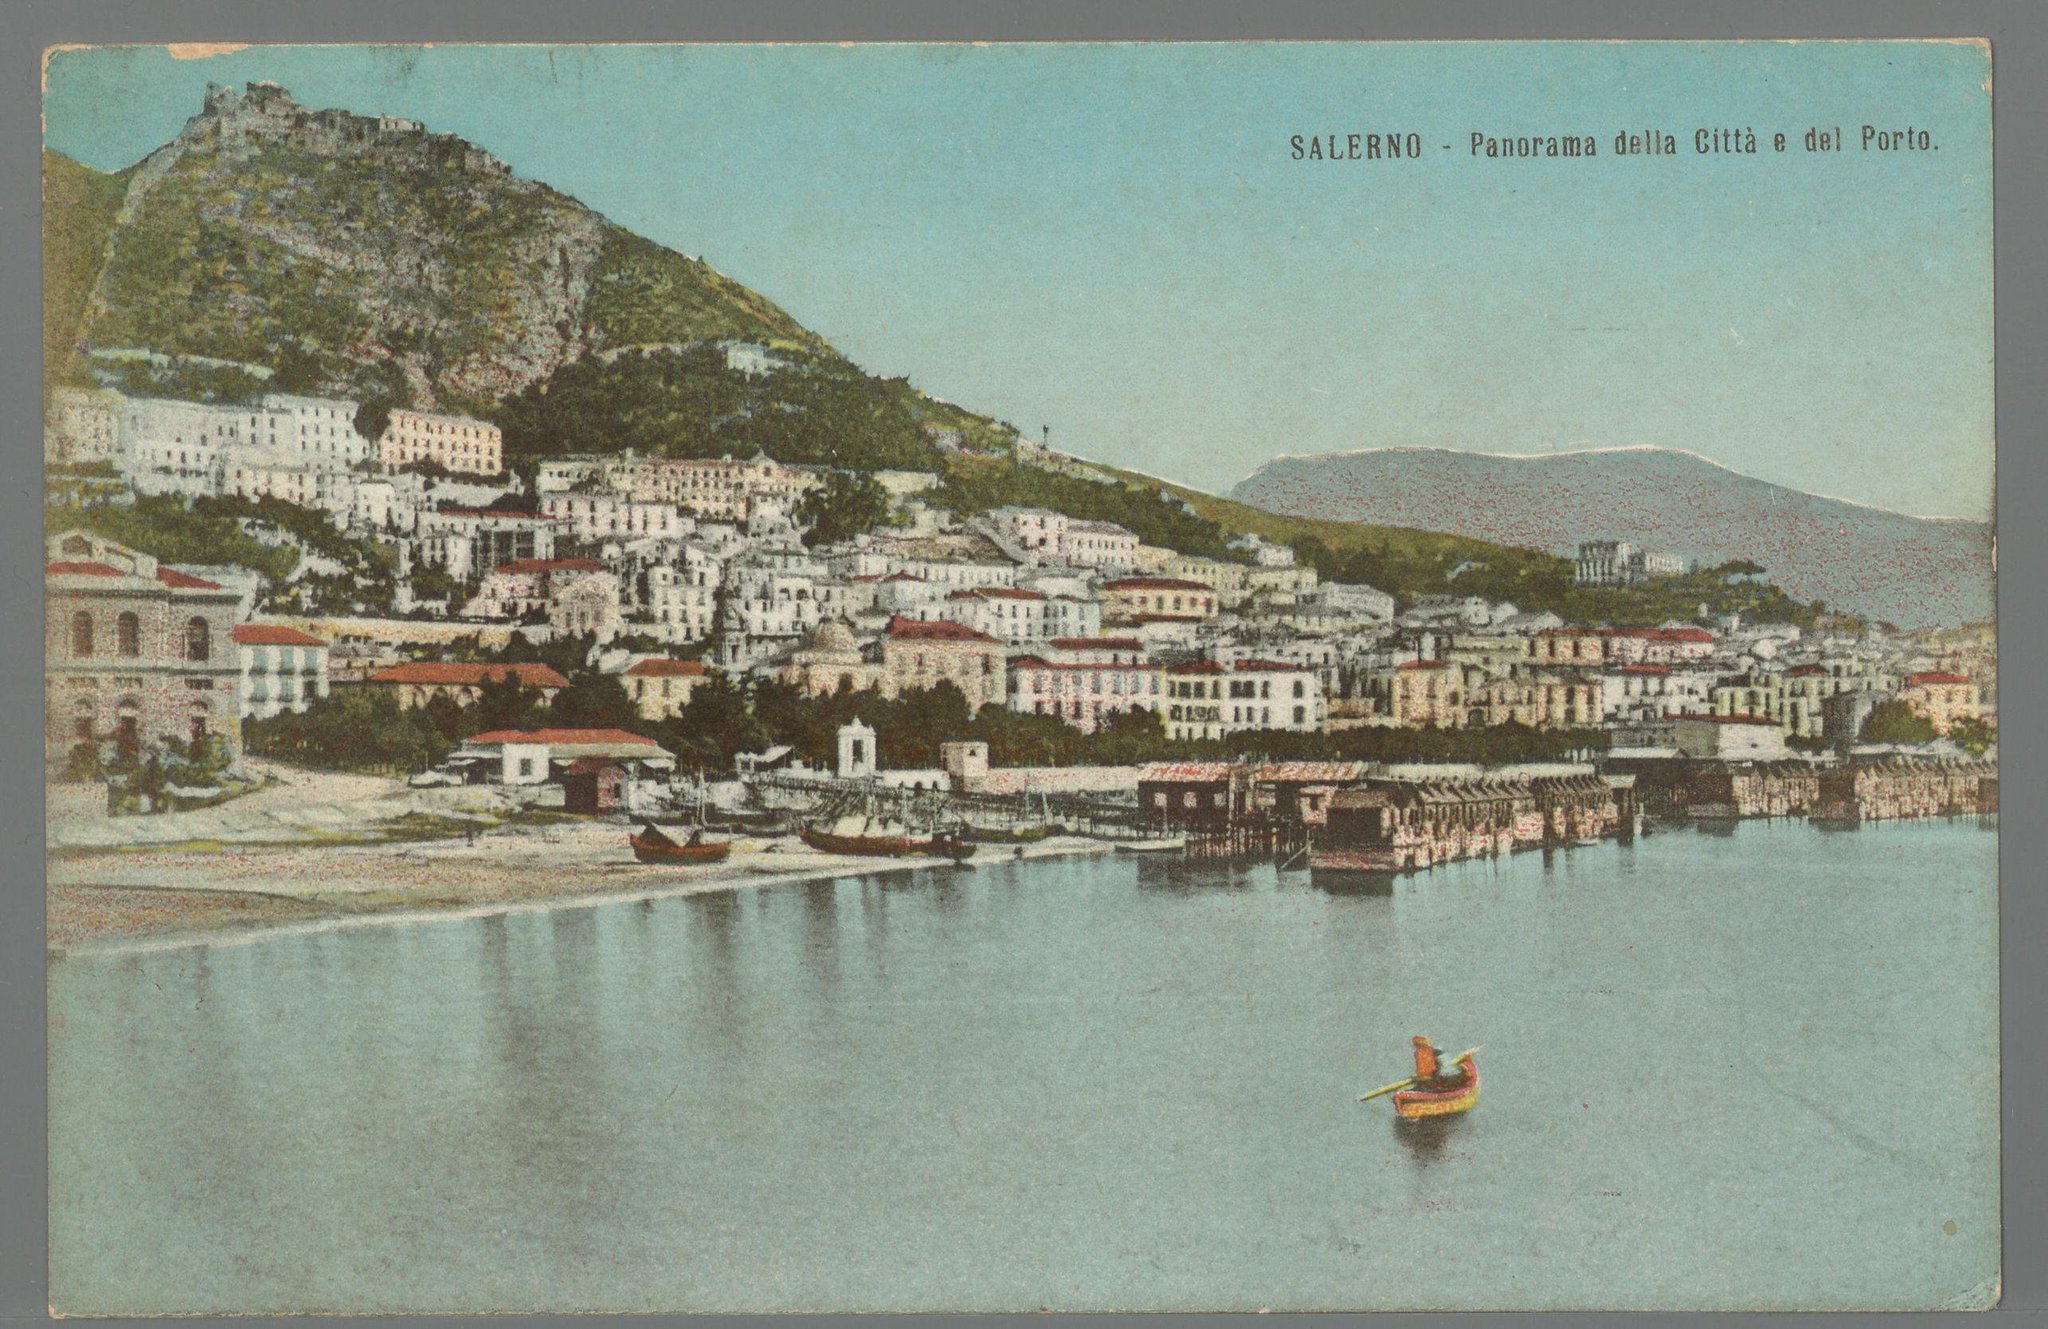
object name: ansichtkaart, prentbriefkaart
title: Salerno. Panorama della Città e del Porto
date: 1906-1920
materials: cardboard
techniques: photograph, lithograph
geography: salerno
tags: gulf, bay, landscapes with waters, waterscapes, seascapes (in the temperate zone) (+ landscape with figures, staffage), city-view, and landscape with man-made constructions (+ city(-scape) with figures, staffage), salerno